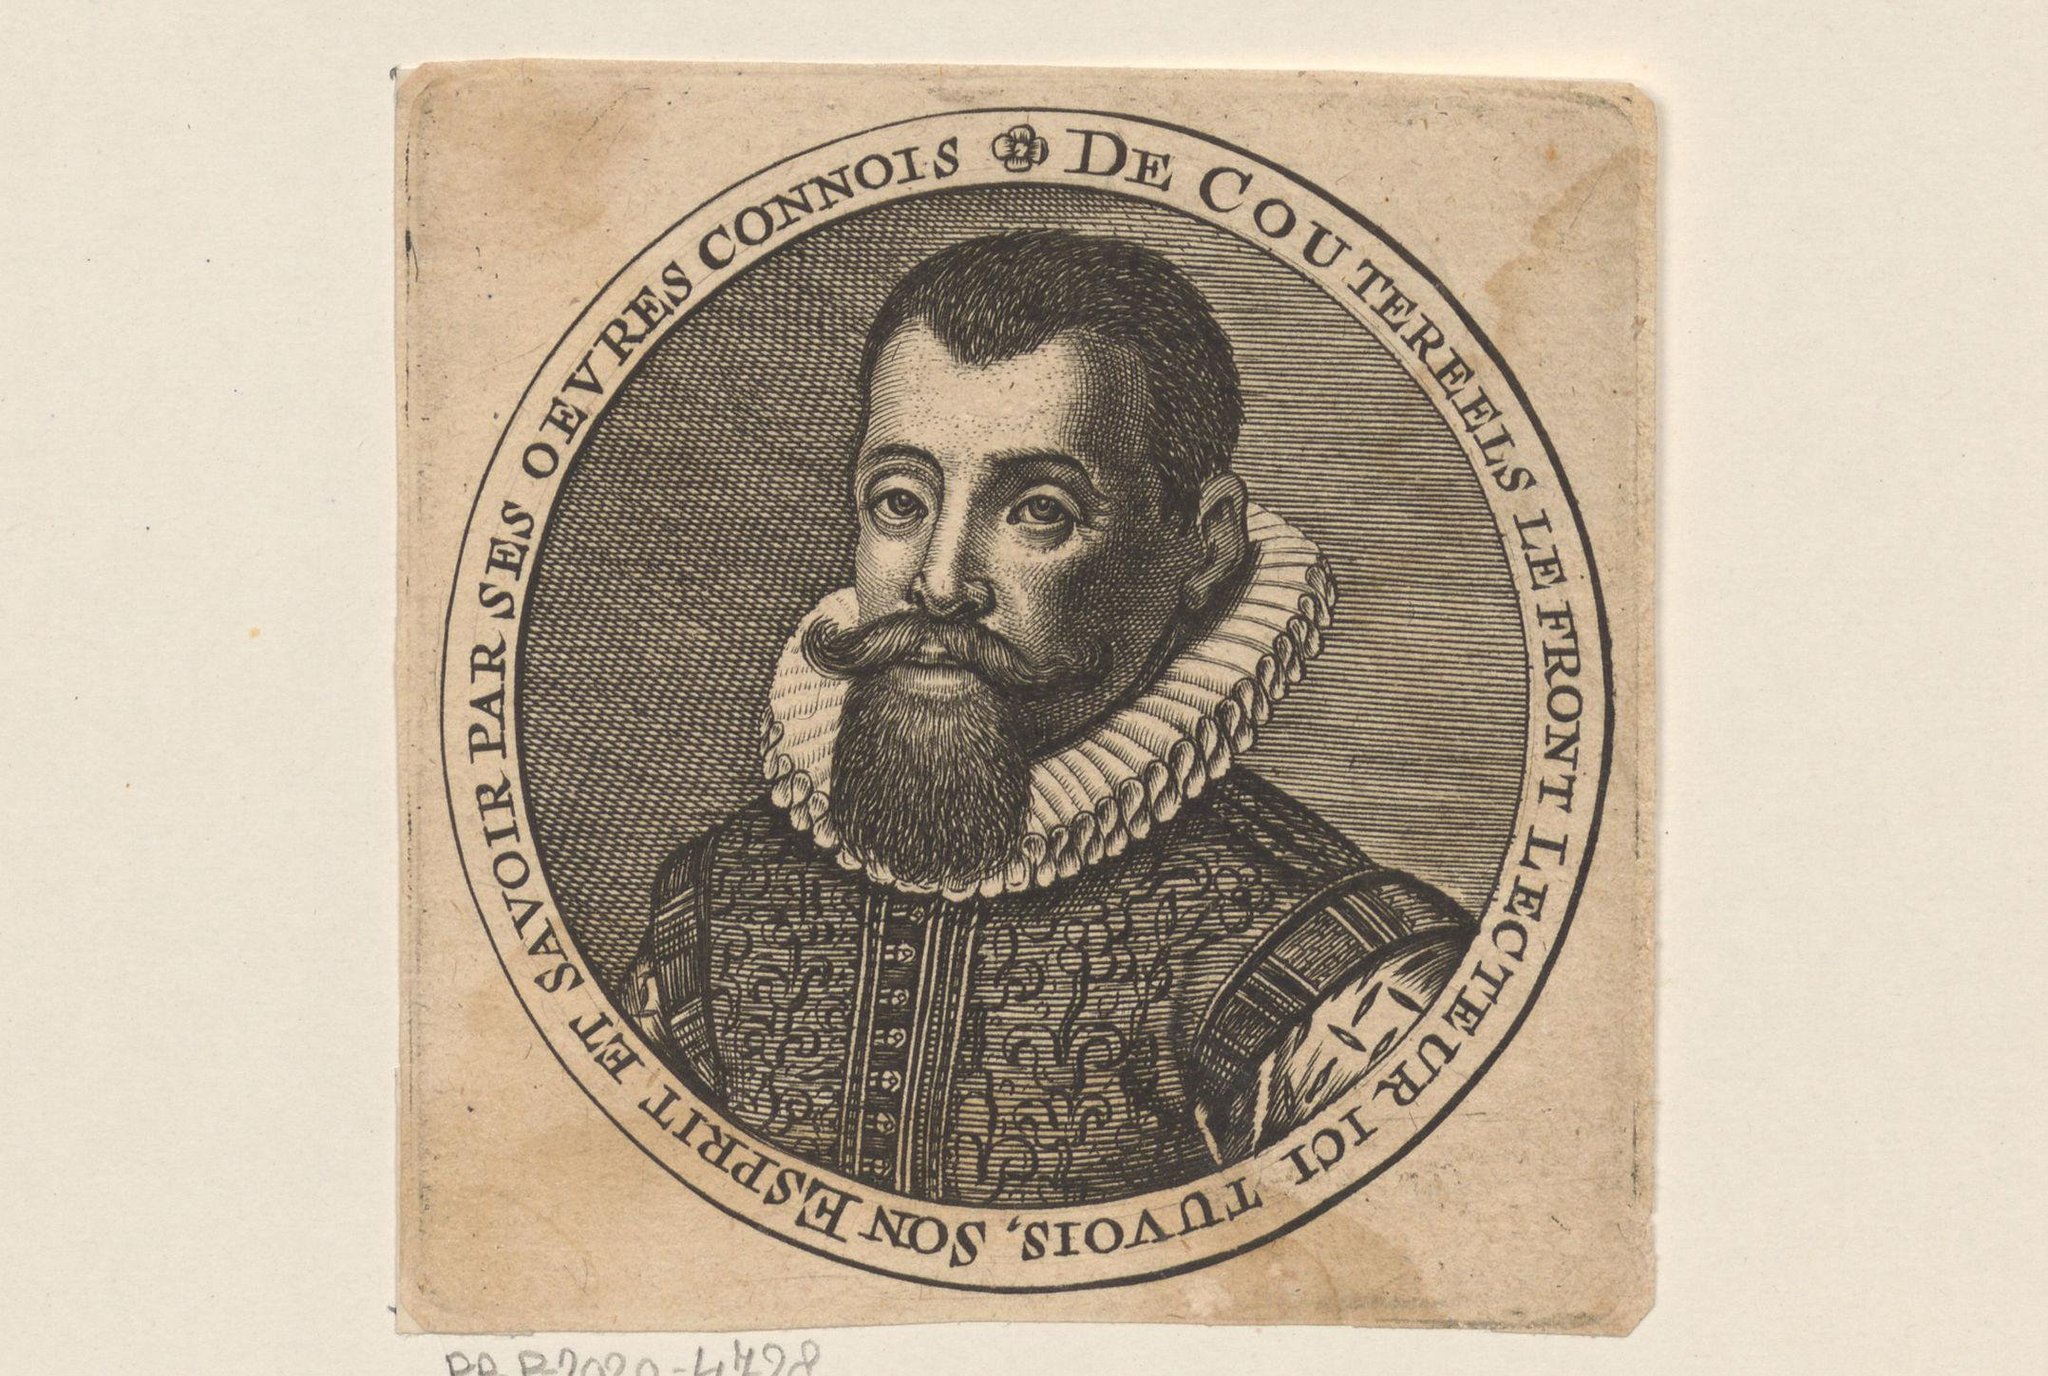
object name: print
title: Portret van Johan Coutereels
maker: Anonymous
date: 1600-1699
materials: paper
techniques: engraving, letterpress printing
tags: antwerp, johan coutereels, historical persons